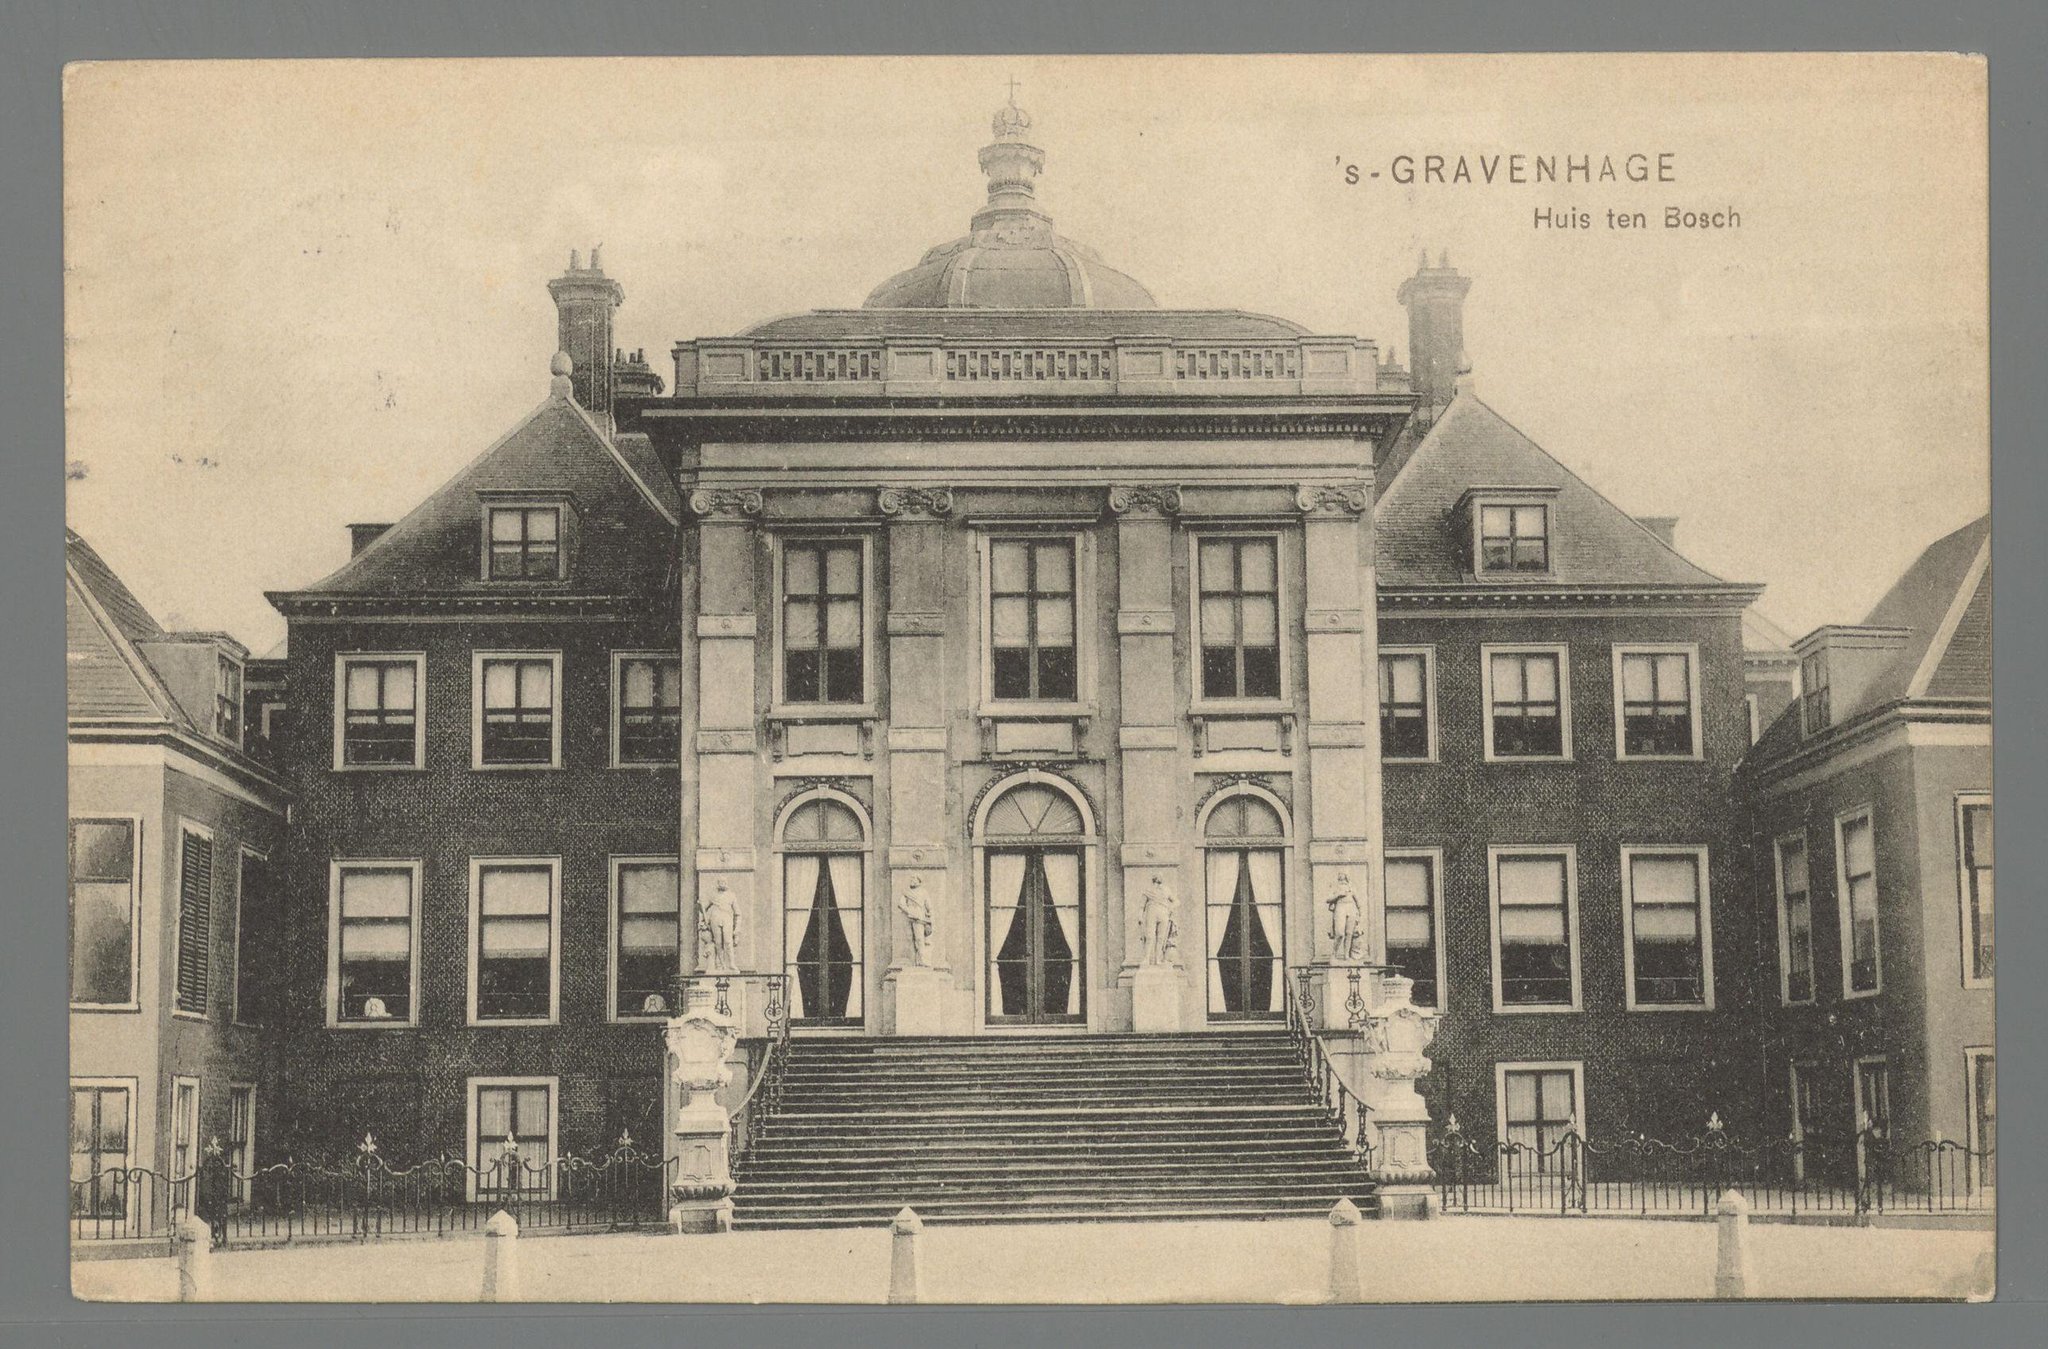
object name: photomechanical print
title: 's-Gravenhage. Huis ten Bosch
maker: Anonymous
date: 1907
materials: cardboard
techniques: photograph, writing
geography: leipzig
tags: palace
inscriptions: postage stamp